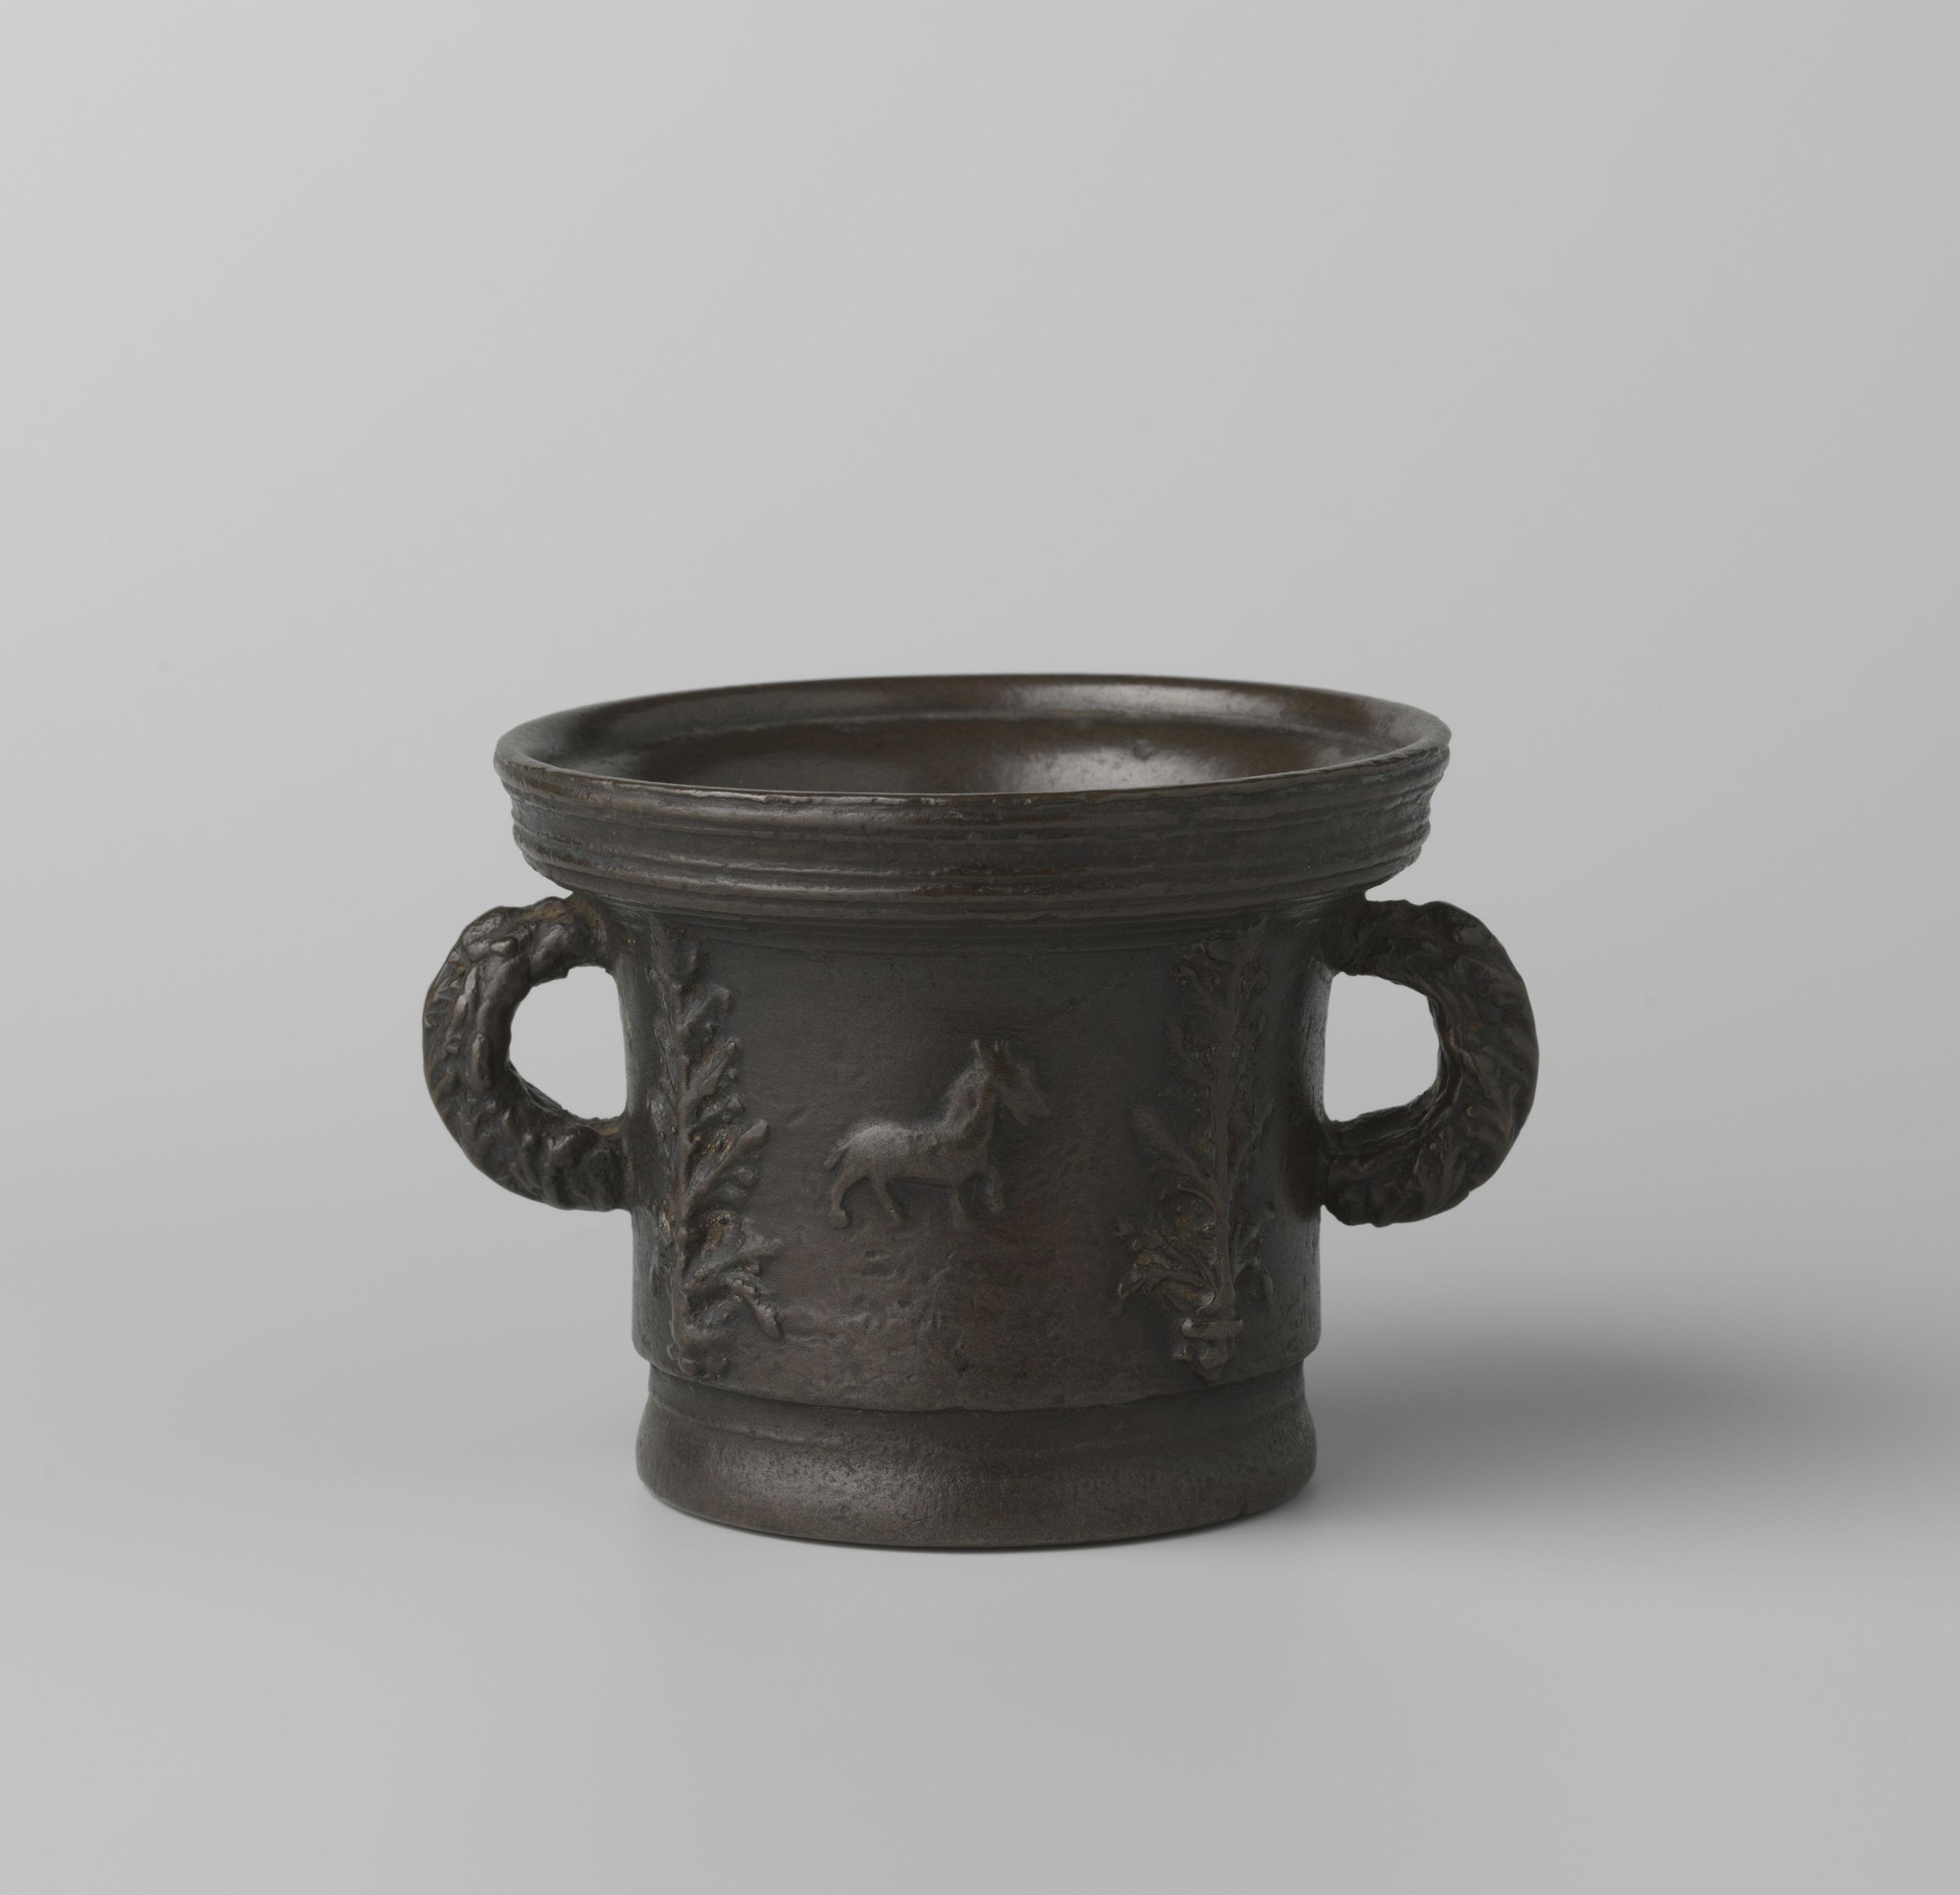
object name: mortar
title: Vijzel versierd met twee paarden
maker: Anonymous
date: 1500-1600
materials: bronze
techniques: casting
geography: italy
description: Mortar. Bronze. Italy, 16th century.